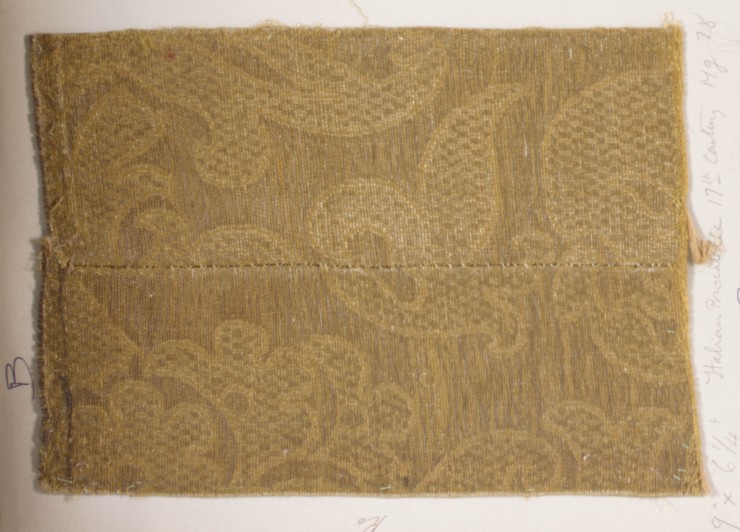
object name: fragment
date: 1601-1700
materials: metal thread, silk